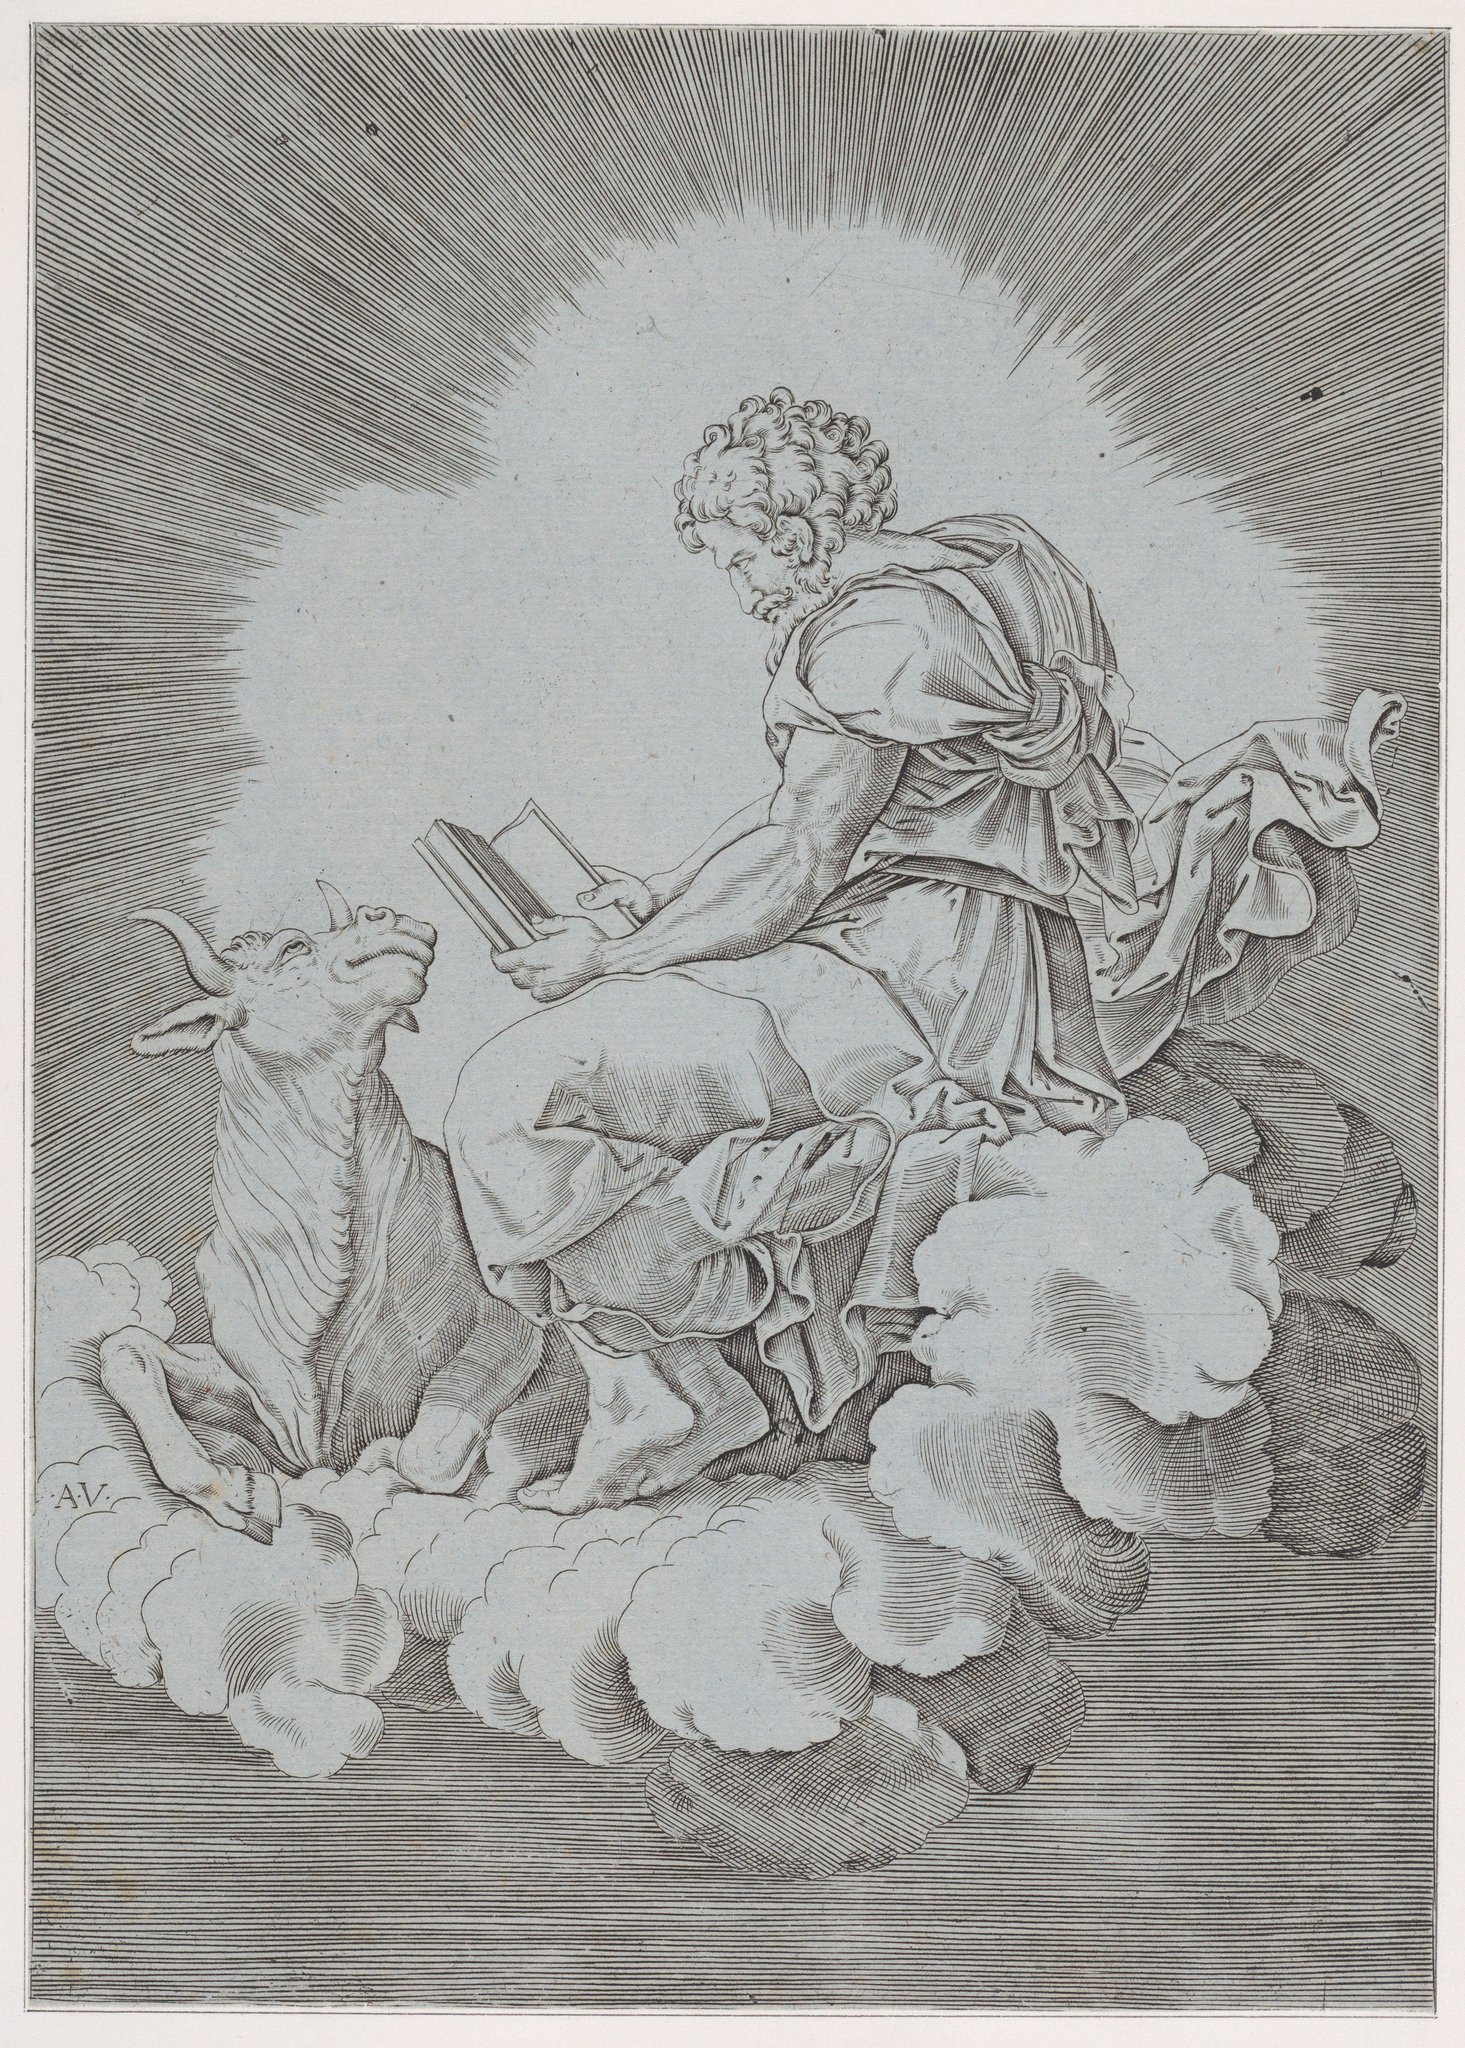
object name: print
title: Saint Luke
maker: anonymous, italian, 16th to early 17th century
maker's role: artist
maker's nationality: italian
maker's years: 1500-1640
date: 1514-1536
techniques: engraving